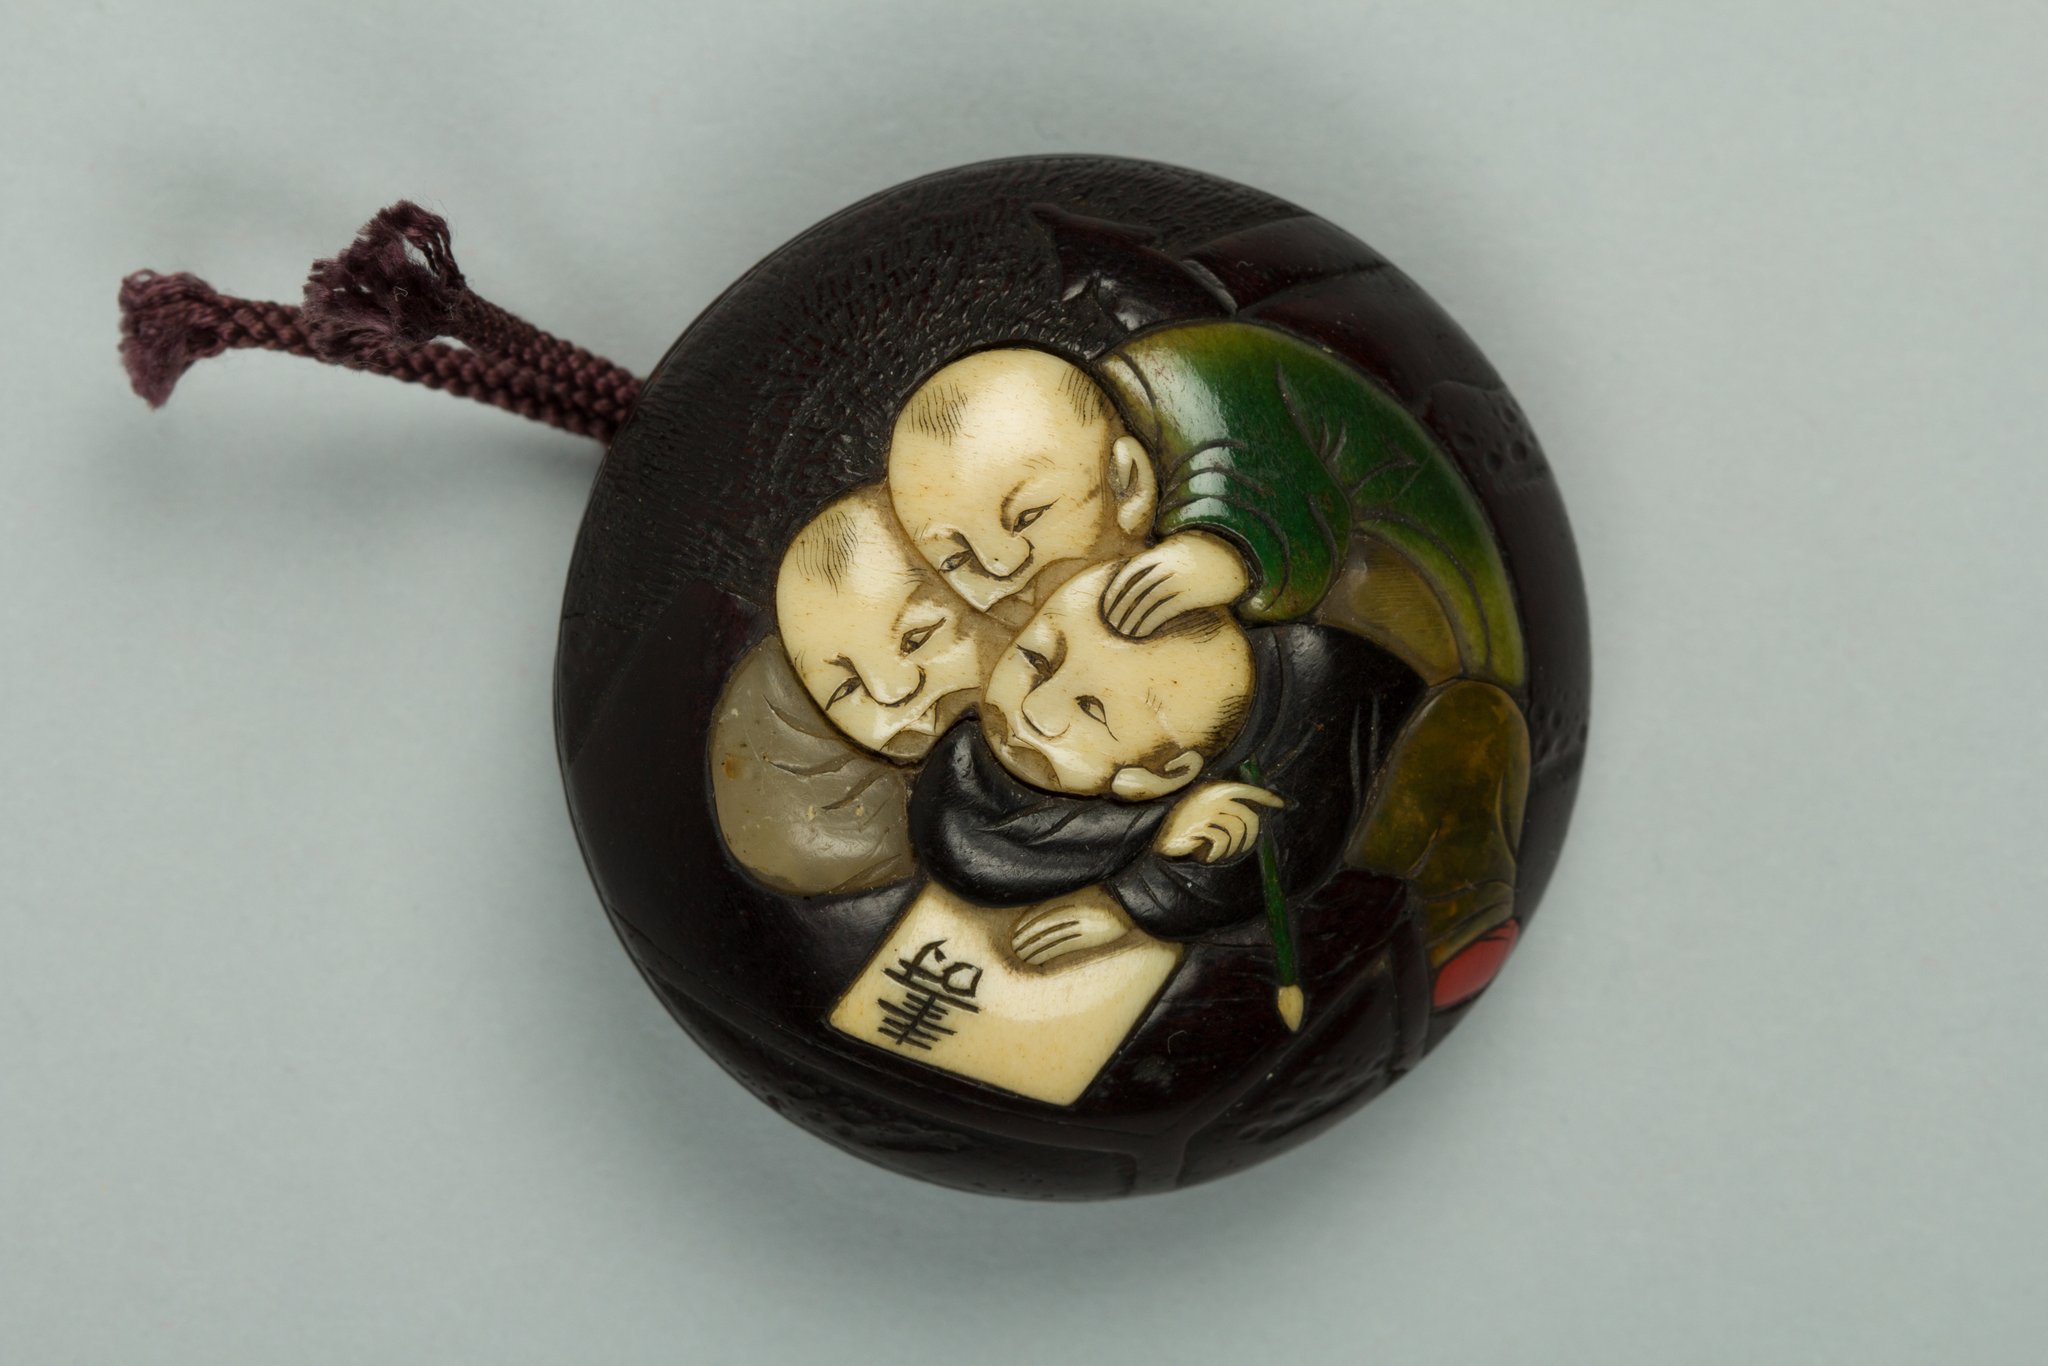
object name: netsuke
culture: japanese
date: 1801-1900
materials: ivory, wood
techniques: inlay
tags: children